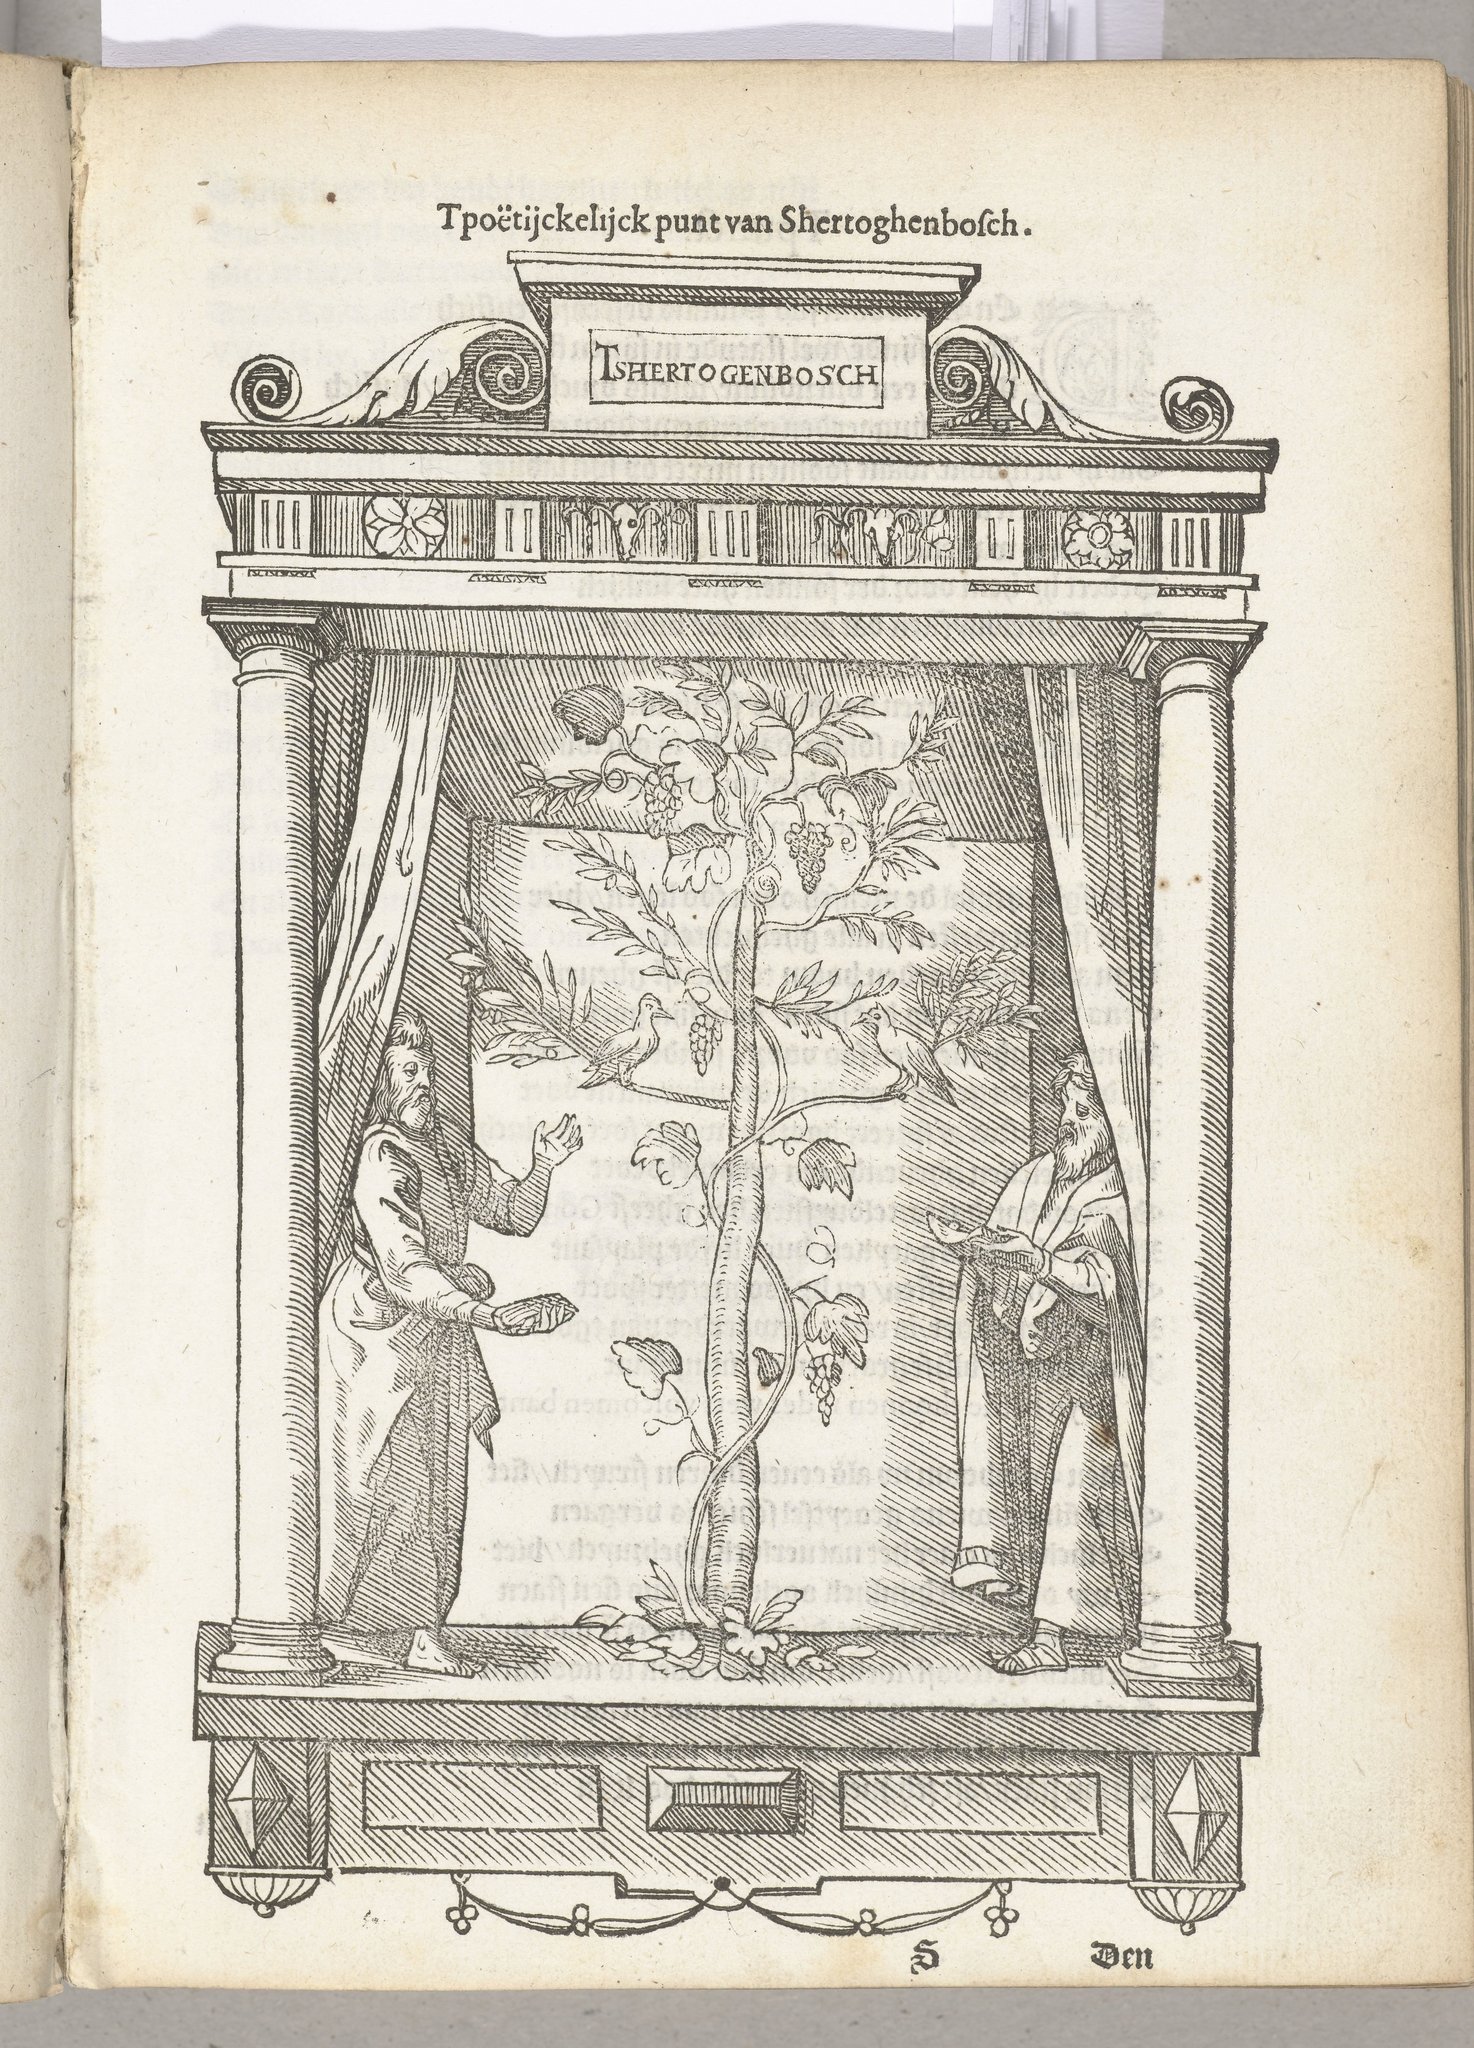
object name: print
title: Blazoen van Der Vreuchden Bloeme (Bergen op Zoom), 1561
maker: Anonymous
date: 1561-1562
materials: paper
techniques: woodcut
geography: antwerp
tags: chamber of rhetoric (dutch: 'rederijkerskamer'), antwerp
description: Illustratie in: Spelen van sinne vol scoone moralisacien wtleggingen ende bediedenissen op alle loeflijcke consten waer inne men claerlijck ghelijck in eene spieghel, figuerlijck, poetelijck en retorijckelijck mach aenschouwen hoe nootsakelijck ende dienstelijck die selve consten allen menschen zijn : ghespeelt met octroy der Con. Ma. binnen der stadt van Andtwerpen op dLant-Juweel by die veerthien cameren van Retorijcken die hen daer ghepresenteert hebben den derden dach Augusti int Jaer ons Heeren 1561, op die questie : wat den mensch aldermeest tot conste verwect. Uitgave van 1562, p. Y (3) verso. In het exemplaar in de Rijksmuseum Research Library, signatuur: 325 D 20.